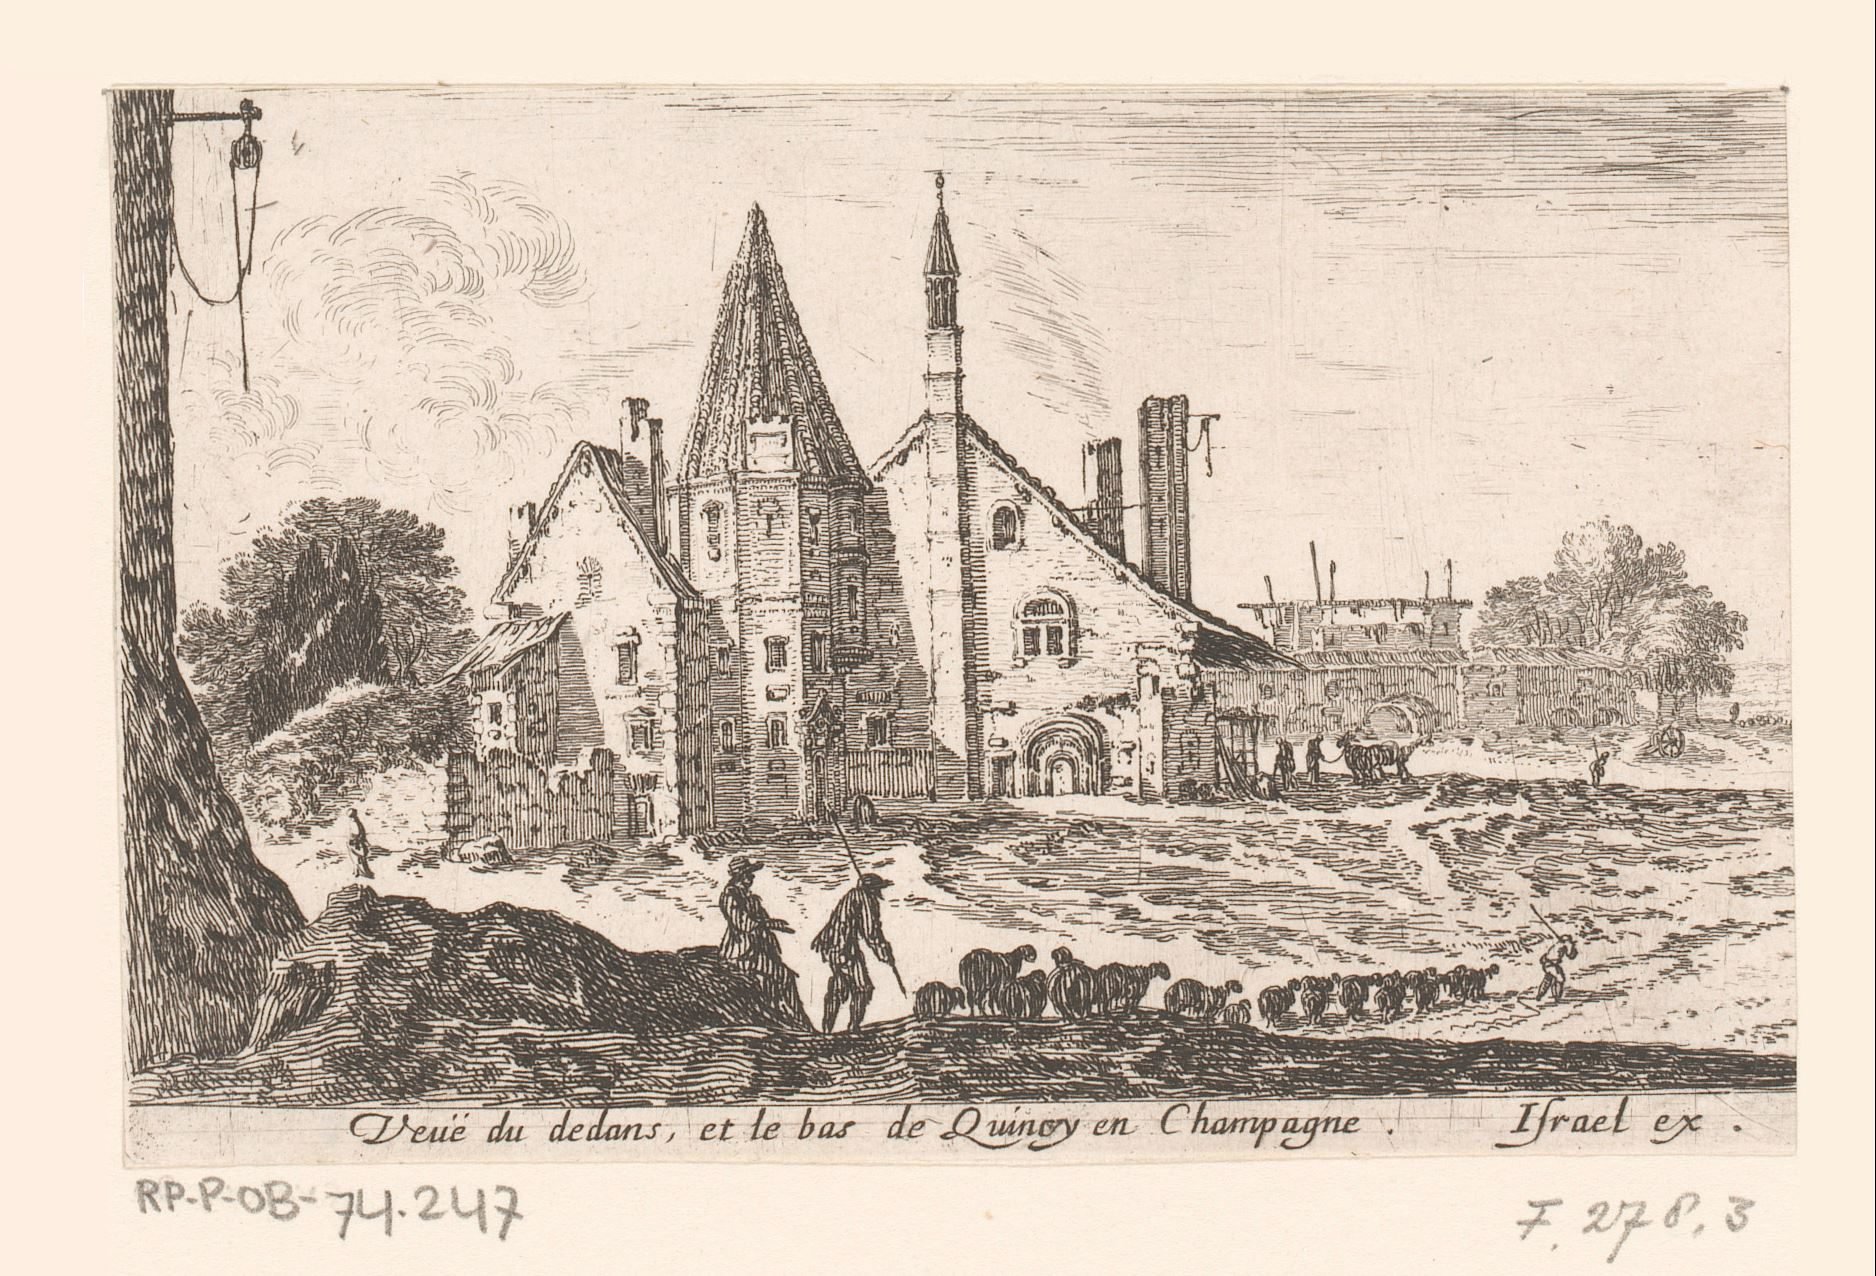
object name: print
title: Gezicht vanuit de abdij van Quincy met schaapsherder met kudde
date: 1631-1691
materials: paper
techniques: etching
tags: herding, herdsman, herdswoman, shepherd, shepherdess, cowherd, etc., landscape with tower or castle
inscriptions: collector's mark: Lugt 240